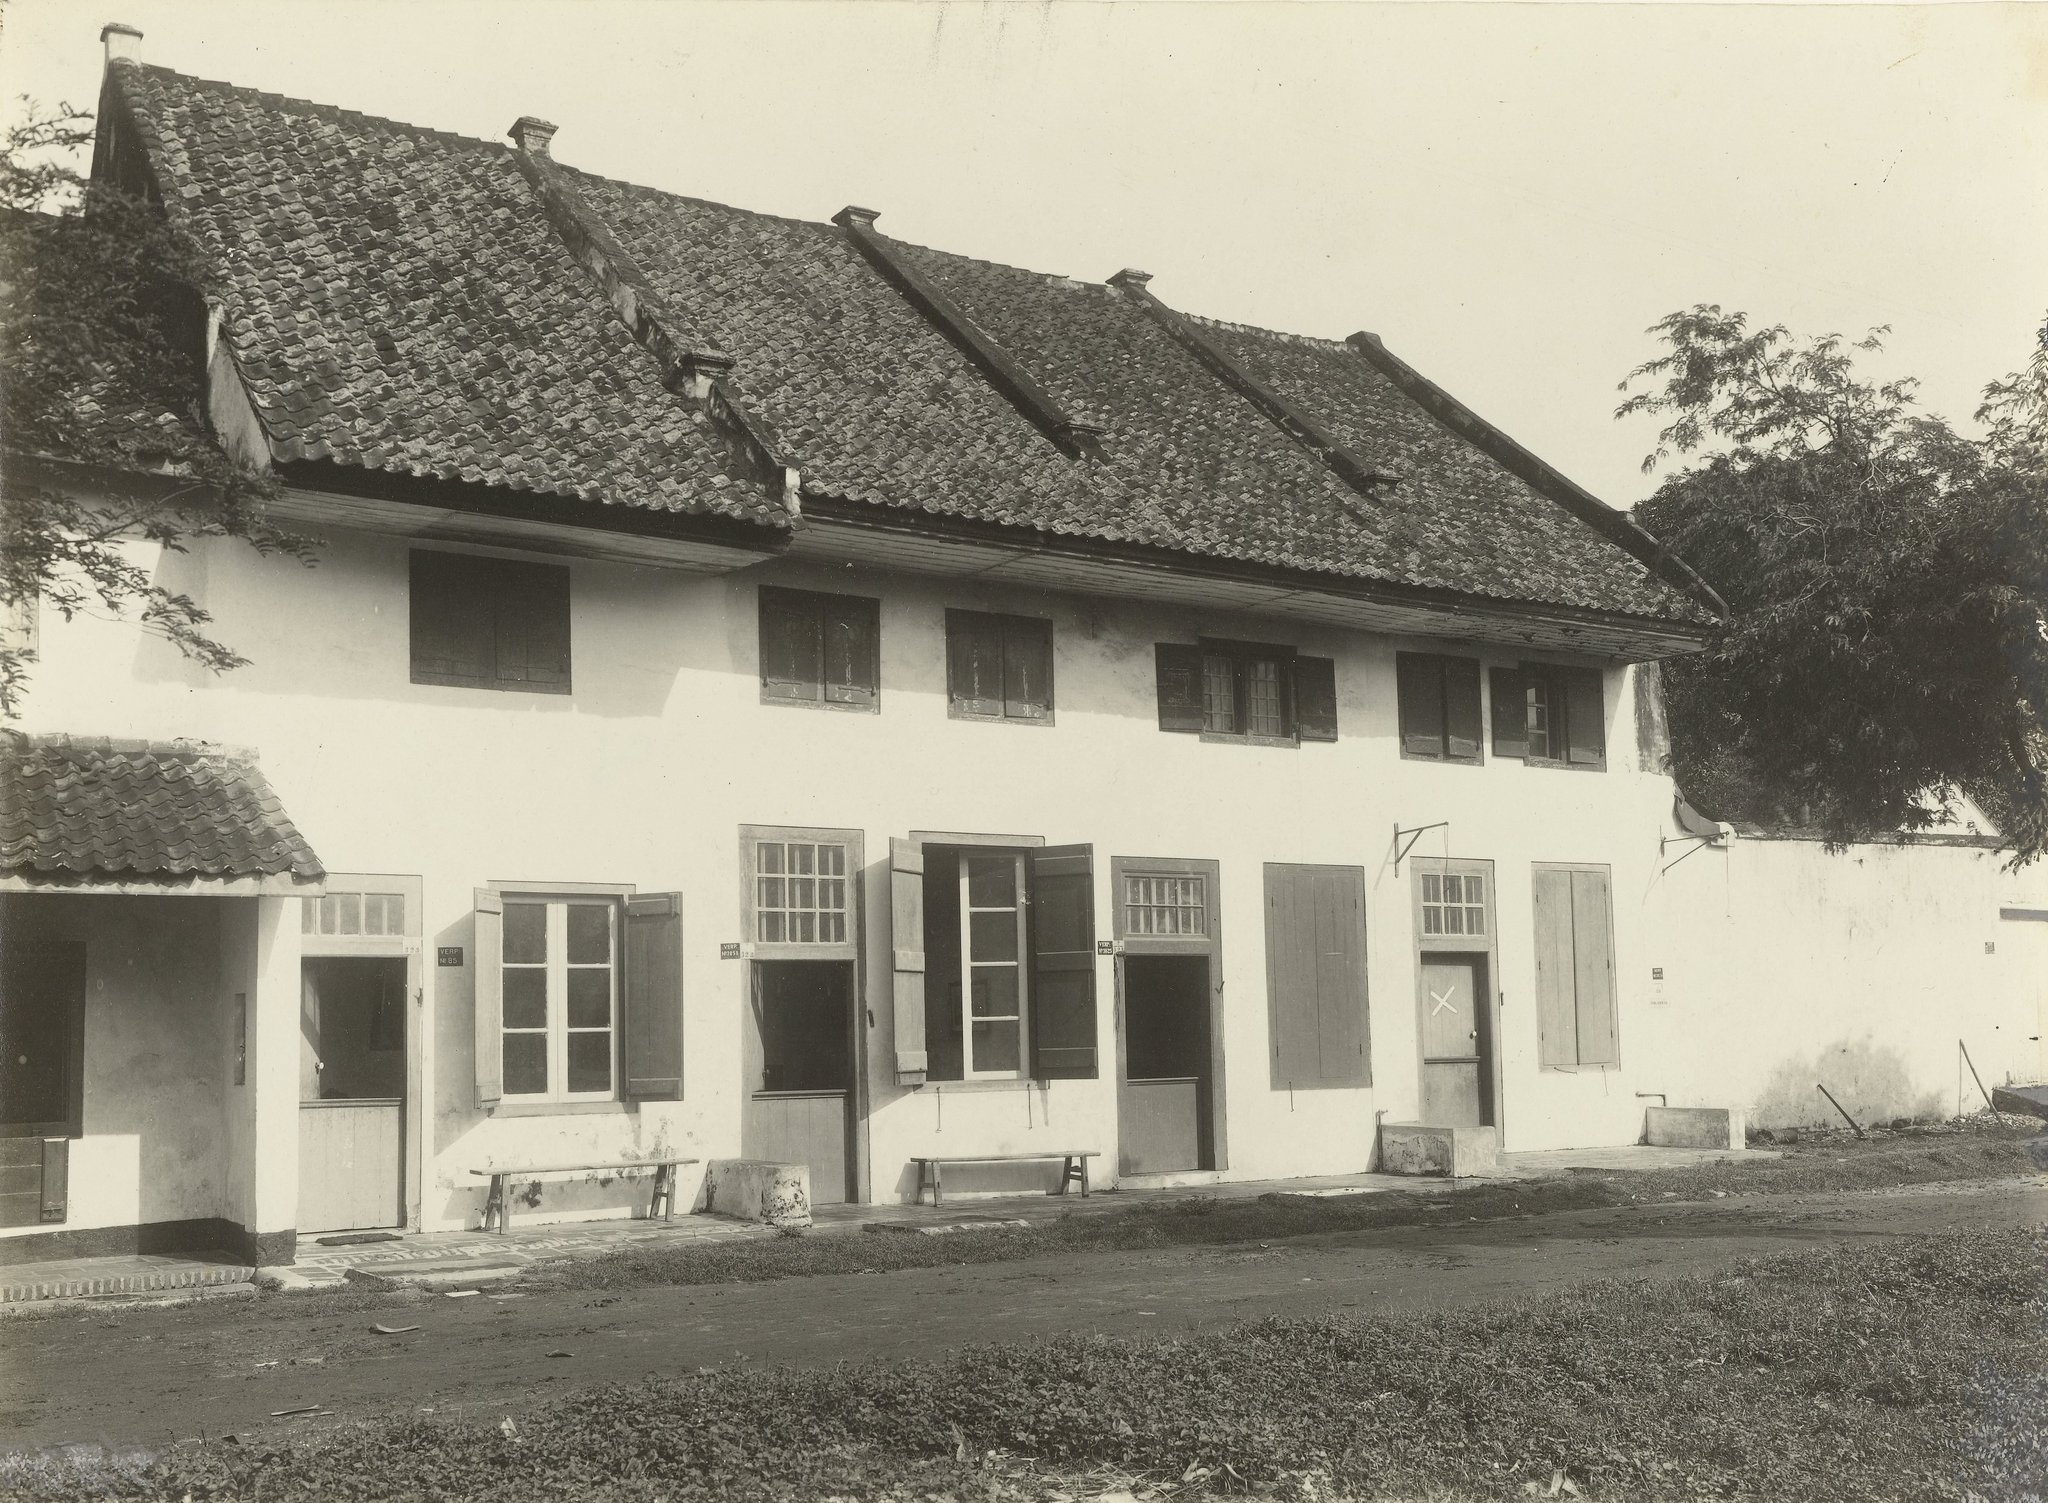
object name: photograph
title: Nederlandse gebouwen in Batavia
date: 1900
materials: paper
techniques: photography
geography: batavia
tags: dutch east indies, the, batavia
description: Eén van zes foto's (zwart-wit) van Nederlandse gebouwen en de Chinese wijk in Batavia (Jakarta), Nederlands-Indië. Merken; achterzijde: stempel: 'chef van den oudheidkundige dienst' en wapen van Nederland. Opmerking: zie NG-1009-A t/m F.